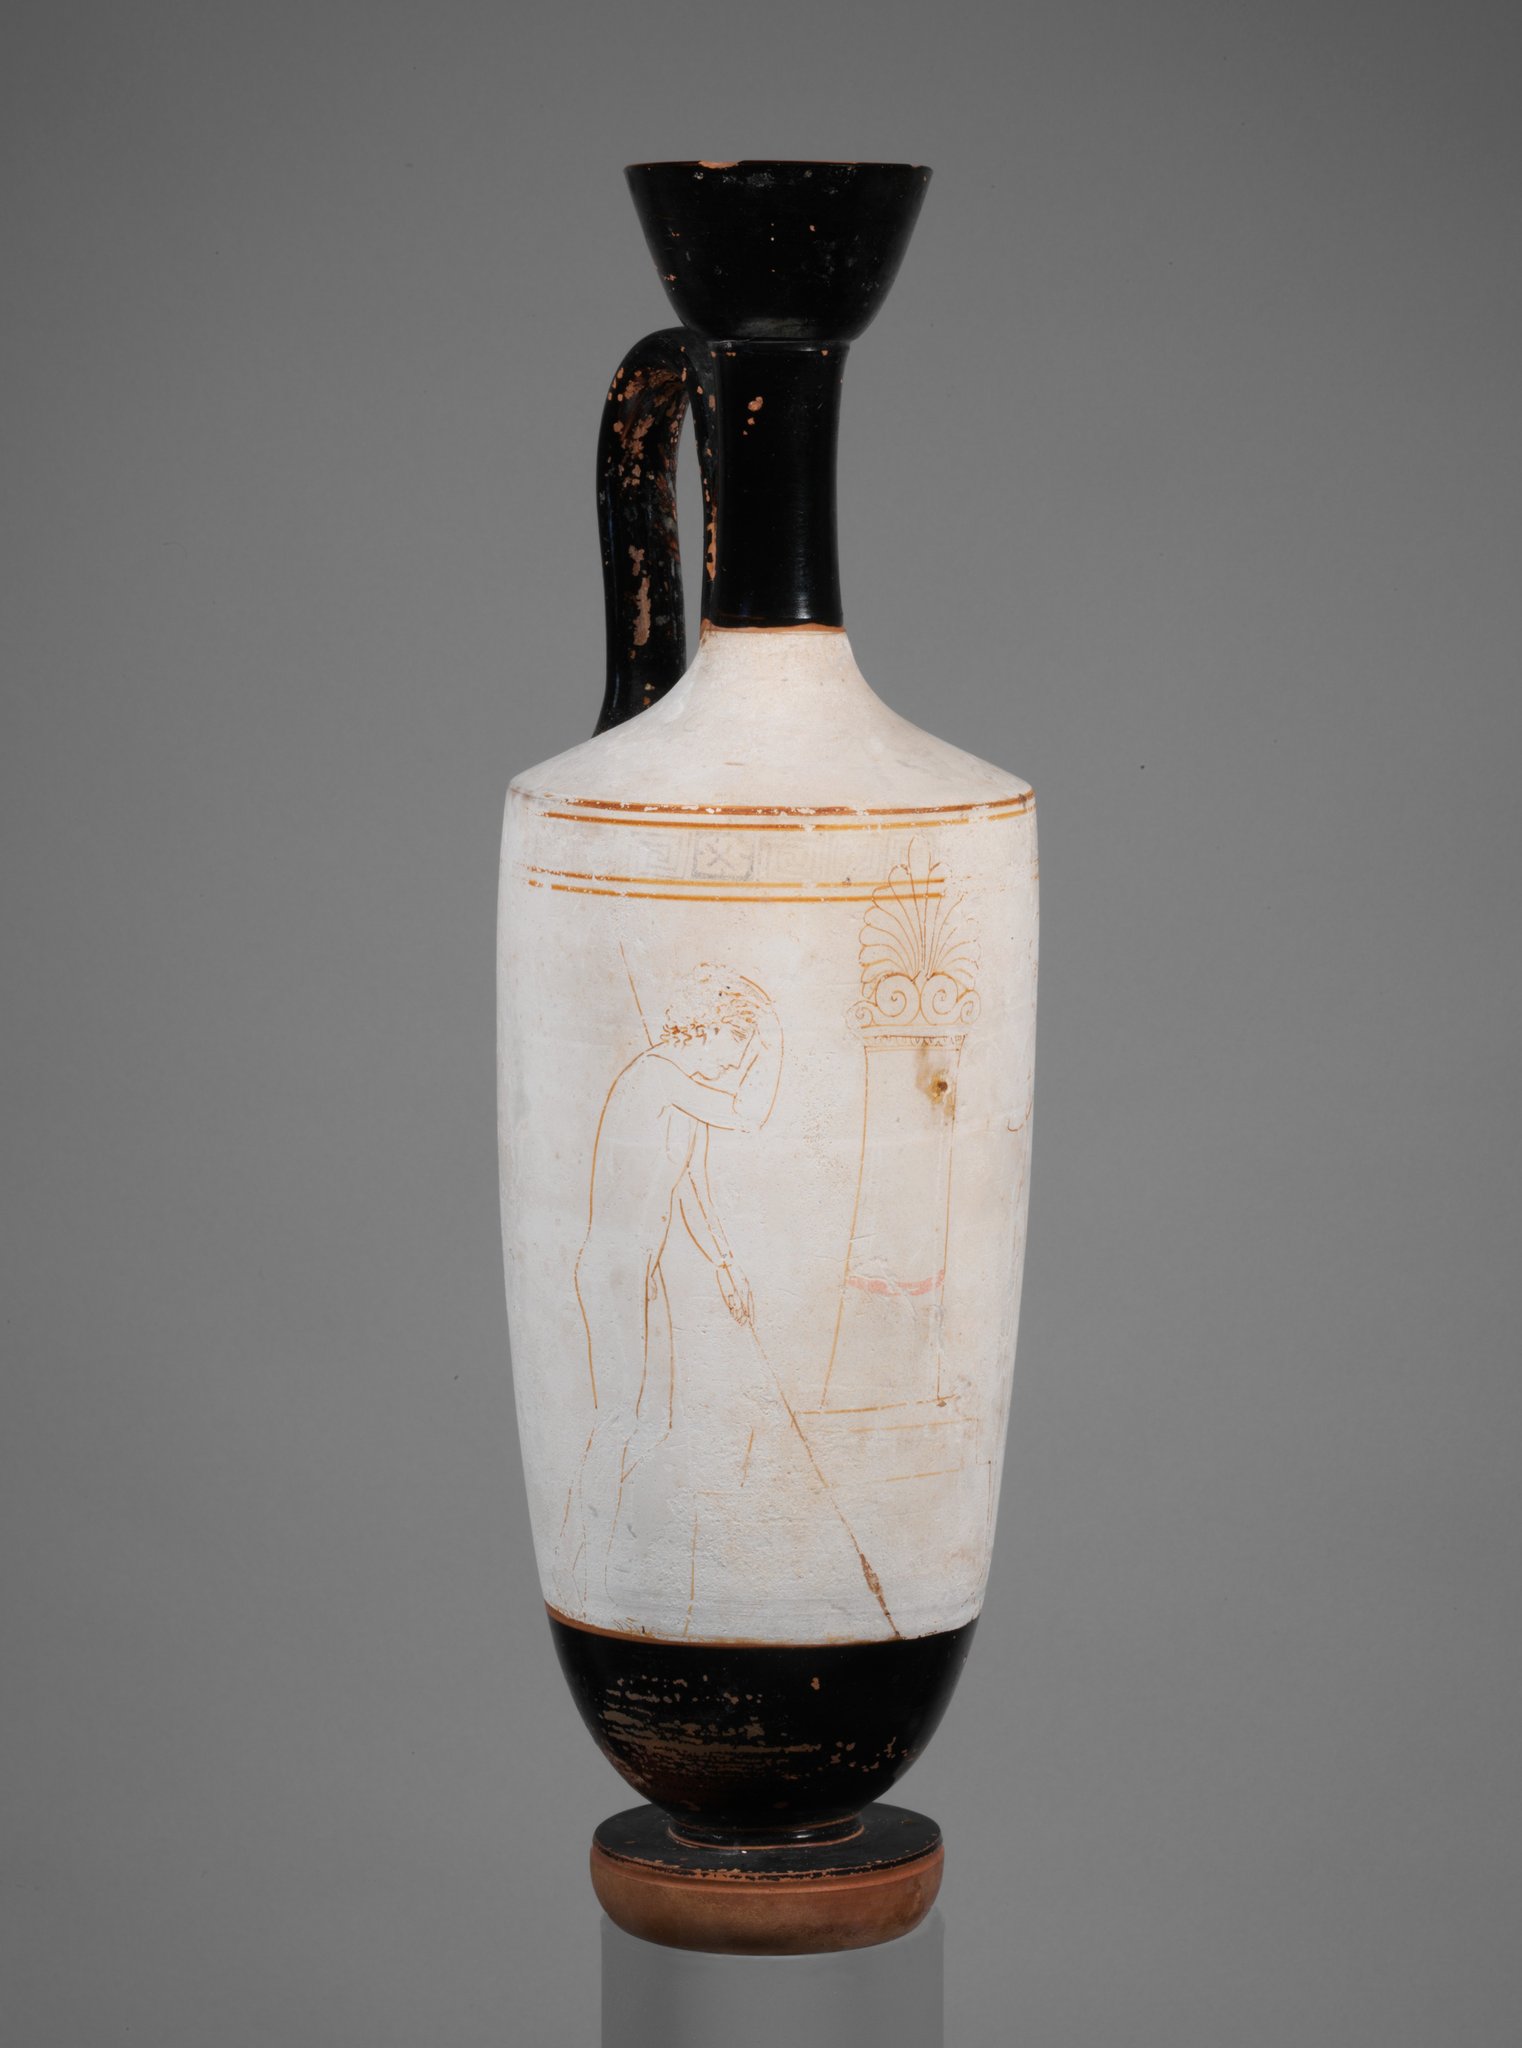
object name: lekythos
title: Terracotta lekythos (oil flask)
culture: greek, attic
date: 440 BCE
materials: terracotta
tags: tombs,male nudes,female nudes